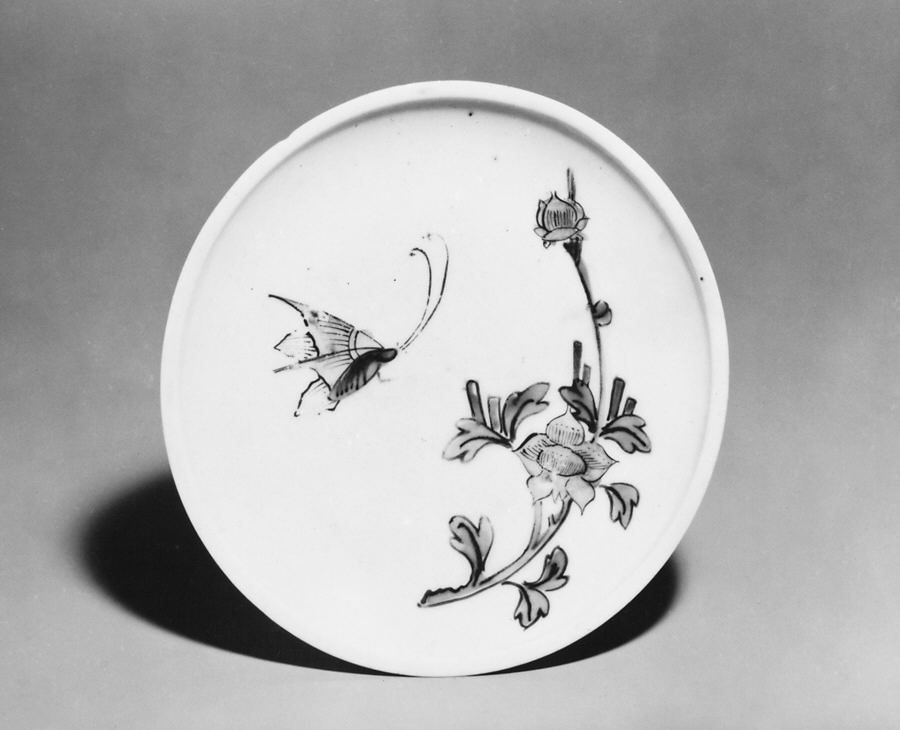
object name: dish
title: Small Dish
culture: japanese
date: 1634-1666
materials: enamel, porcelain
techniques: painting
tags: butterflies